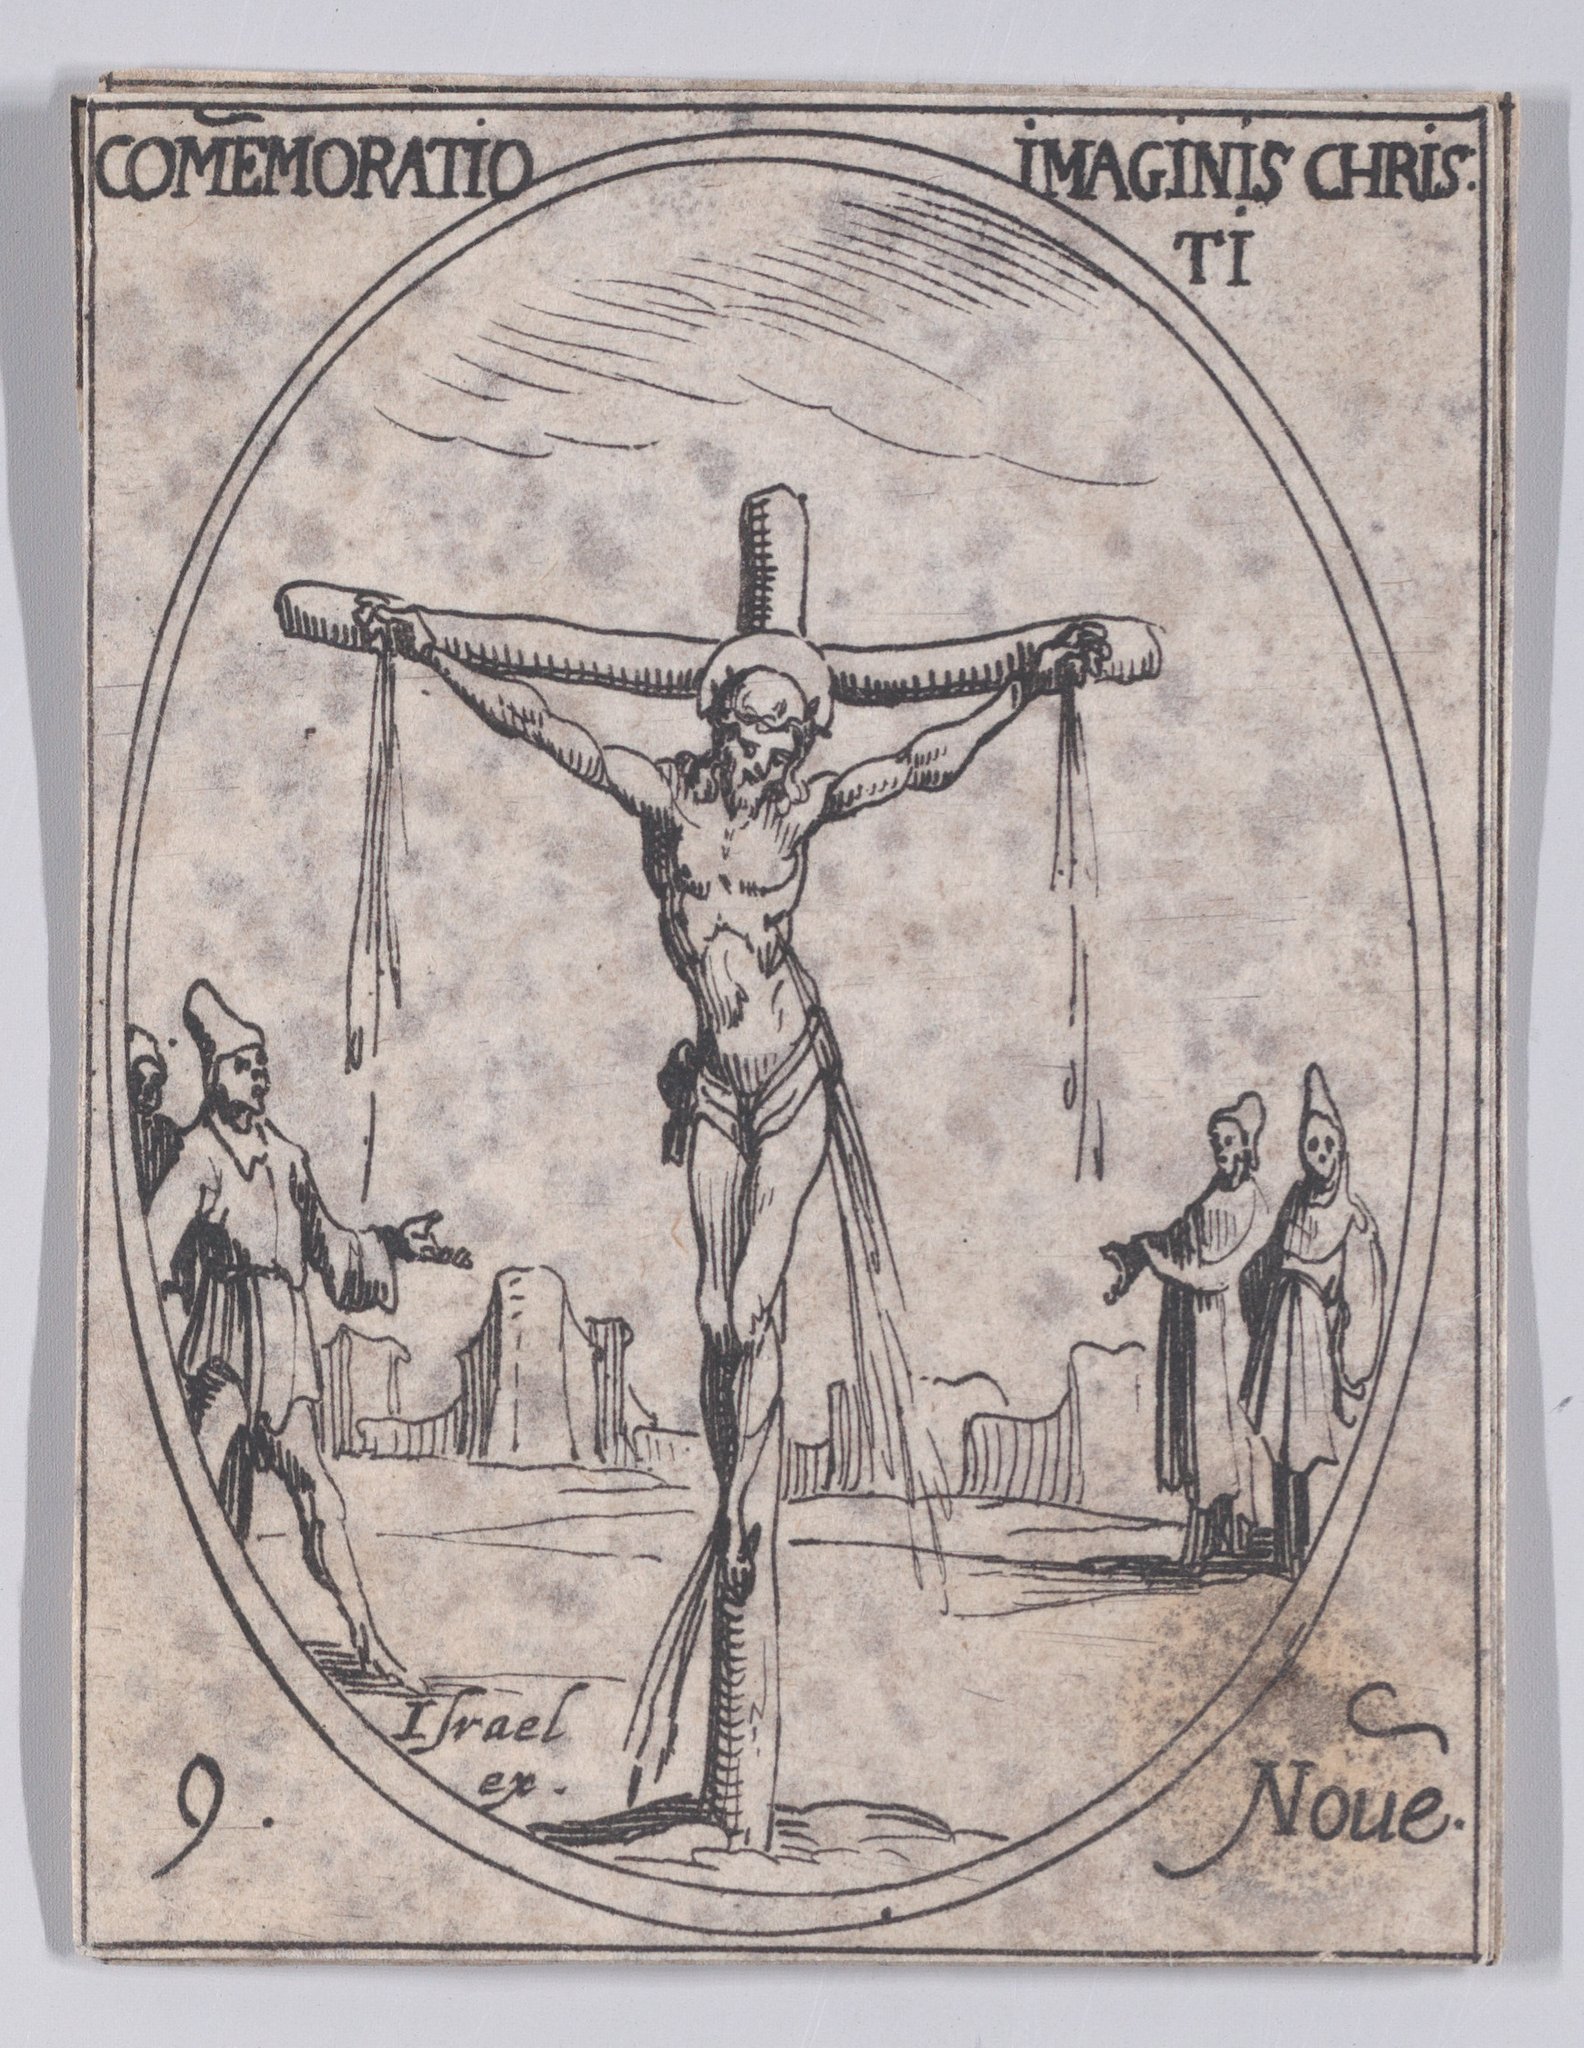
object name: print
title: La Commémoration de l'Image du Christi (The Commemoration of the Image of Christ), November 9th, from "Les Images De Tous Les Saincts et Saintes de L'Année" (Images of All of the Saints and Religious Events of the Year)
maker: jacques callot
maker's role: artist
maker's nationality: french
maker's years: 1592-1635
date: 1636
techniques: etching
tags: christ,crucifixion